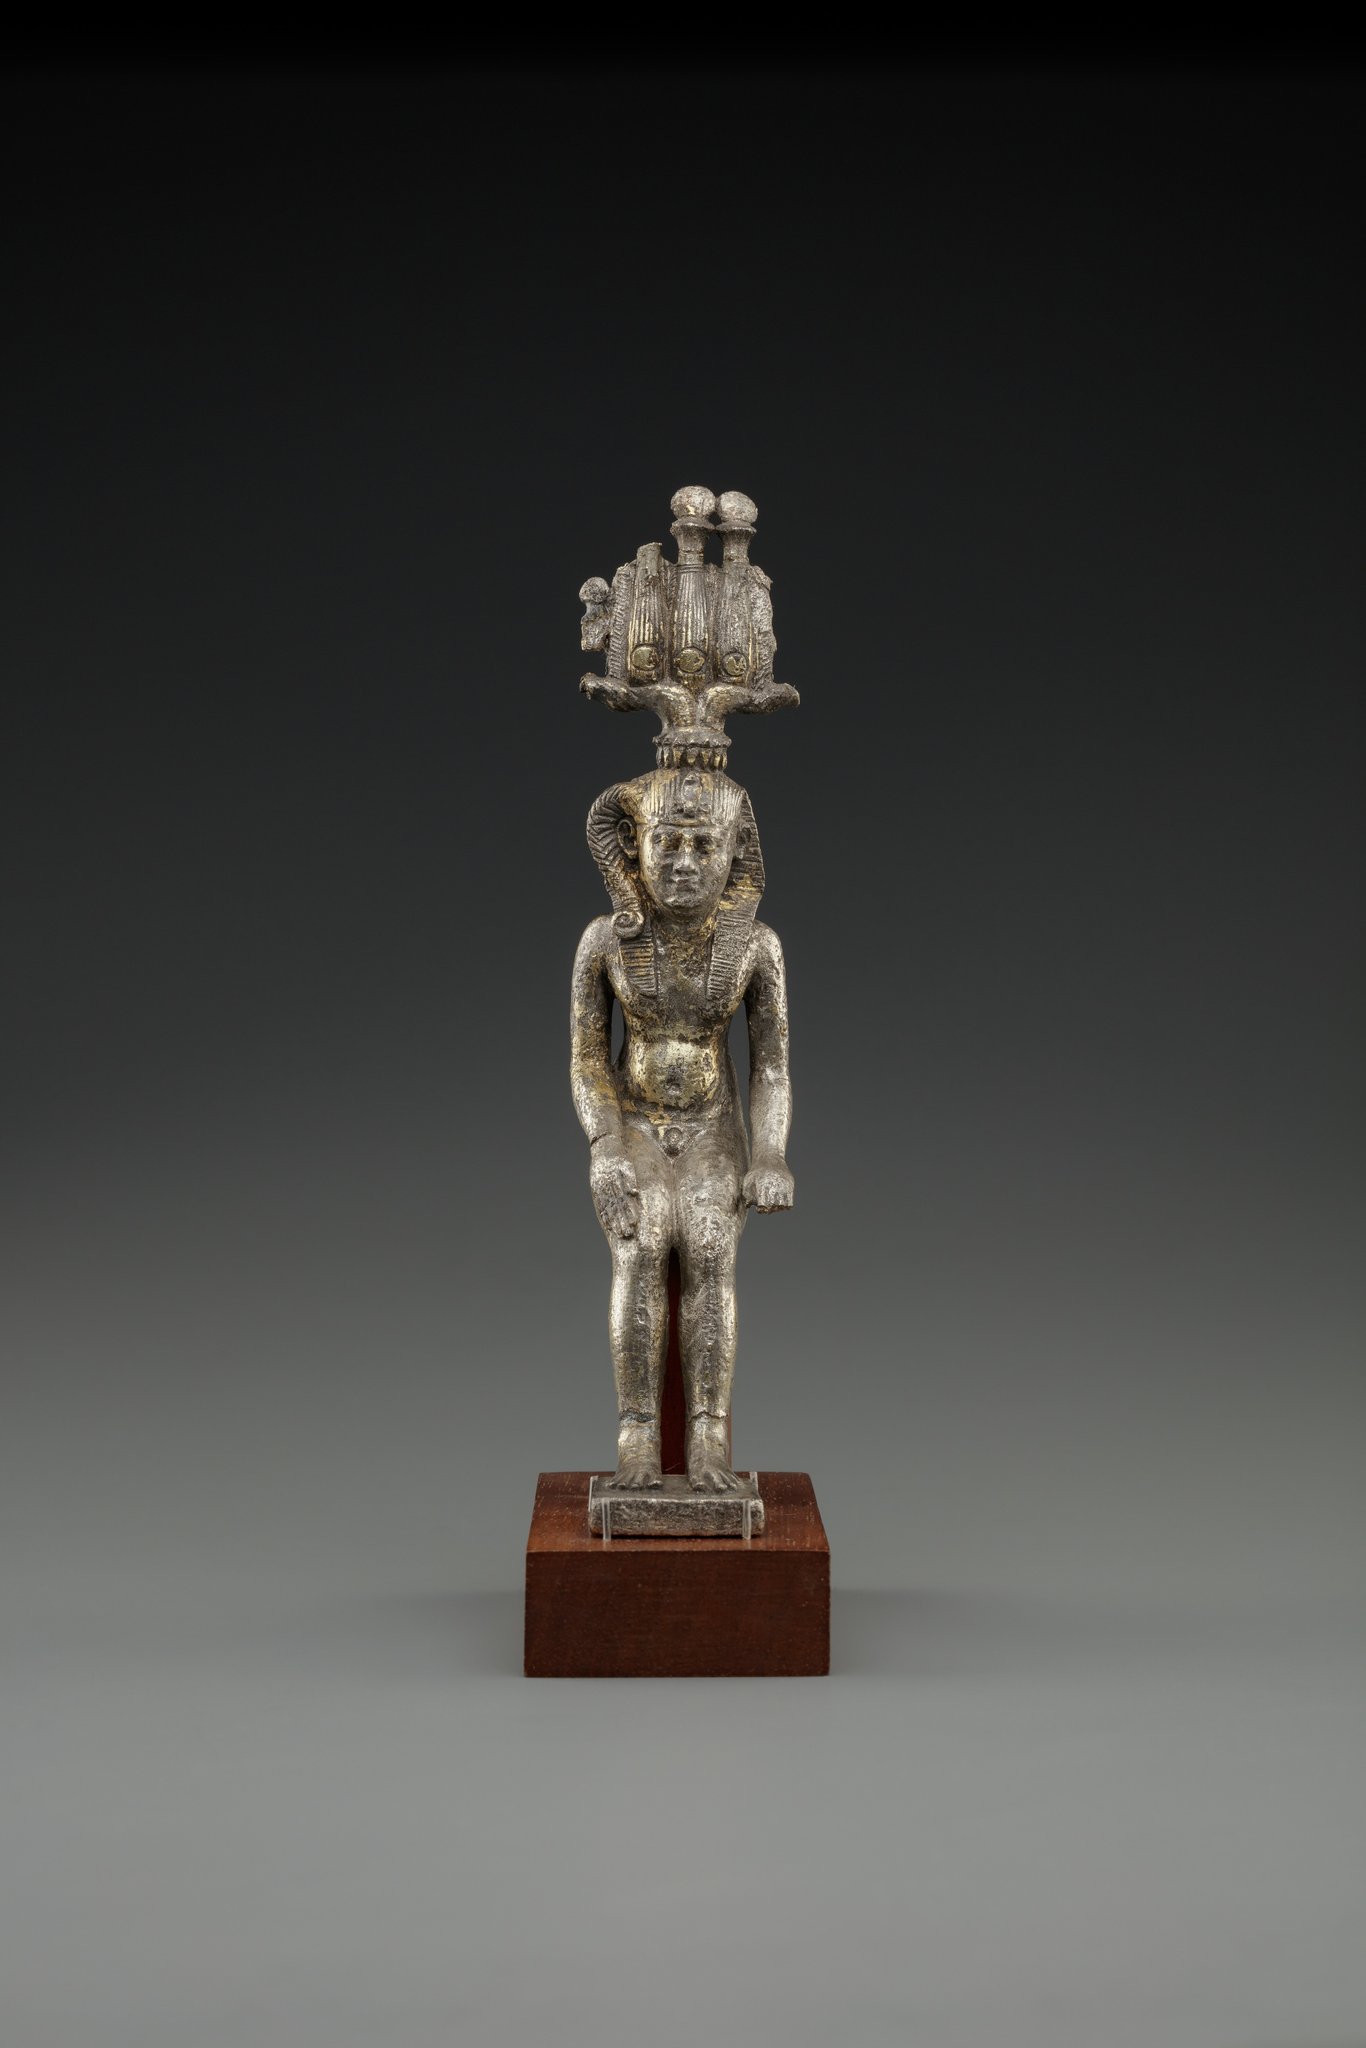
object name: statuette, harpokrates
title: Statuette of Harpokrates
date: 304-30 BCE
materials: gilt silver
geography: egypt